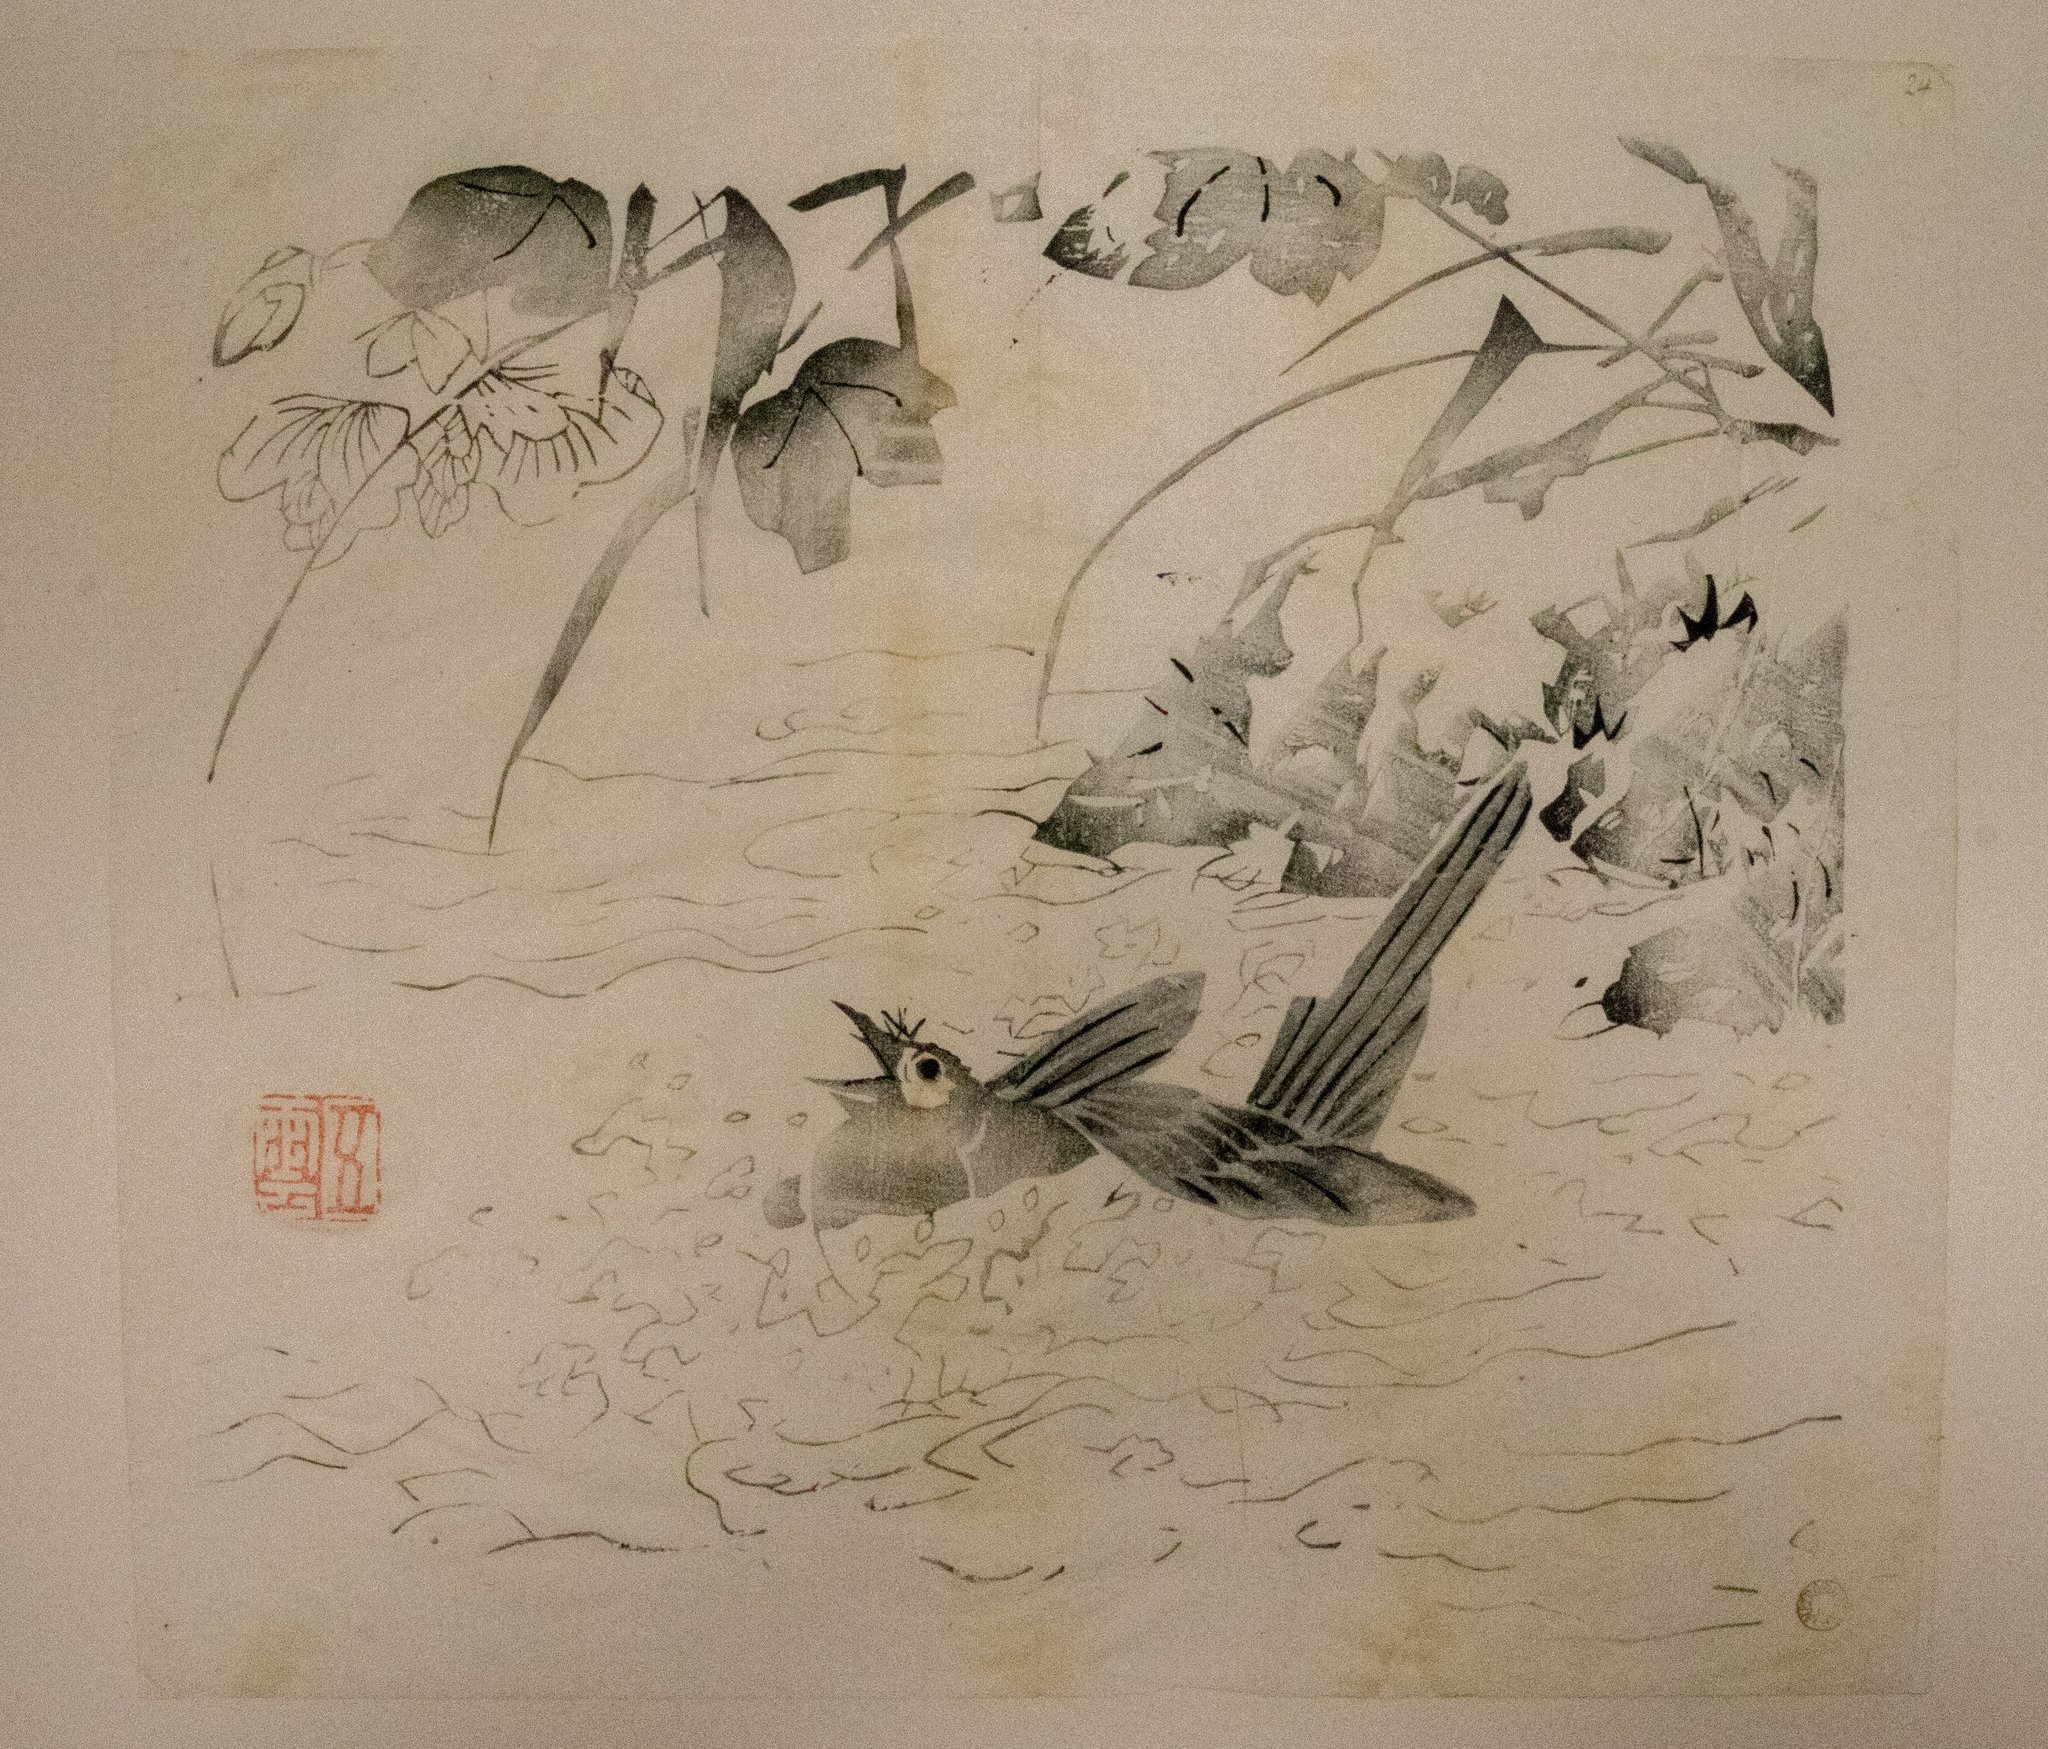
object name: print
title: Page from Shi Zhu Zhai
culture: chinese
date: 1736-1795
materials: ink, paper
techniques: polychrome, woodblock print